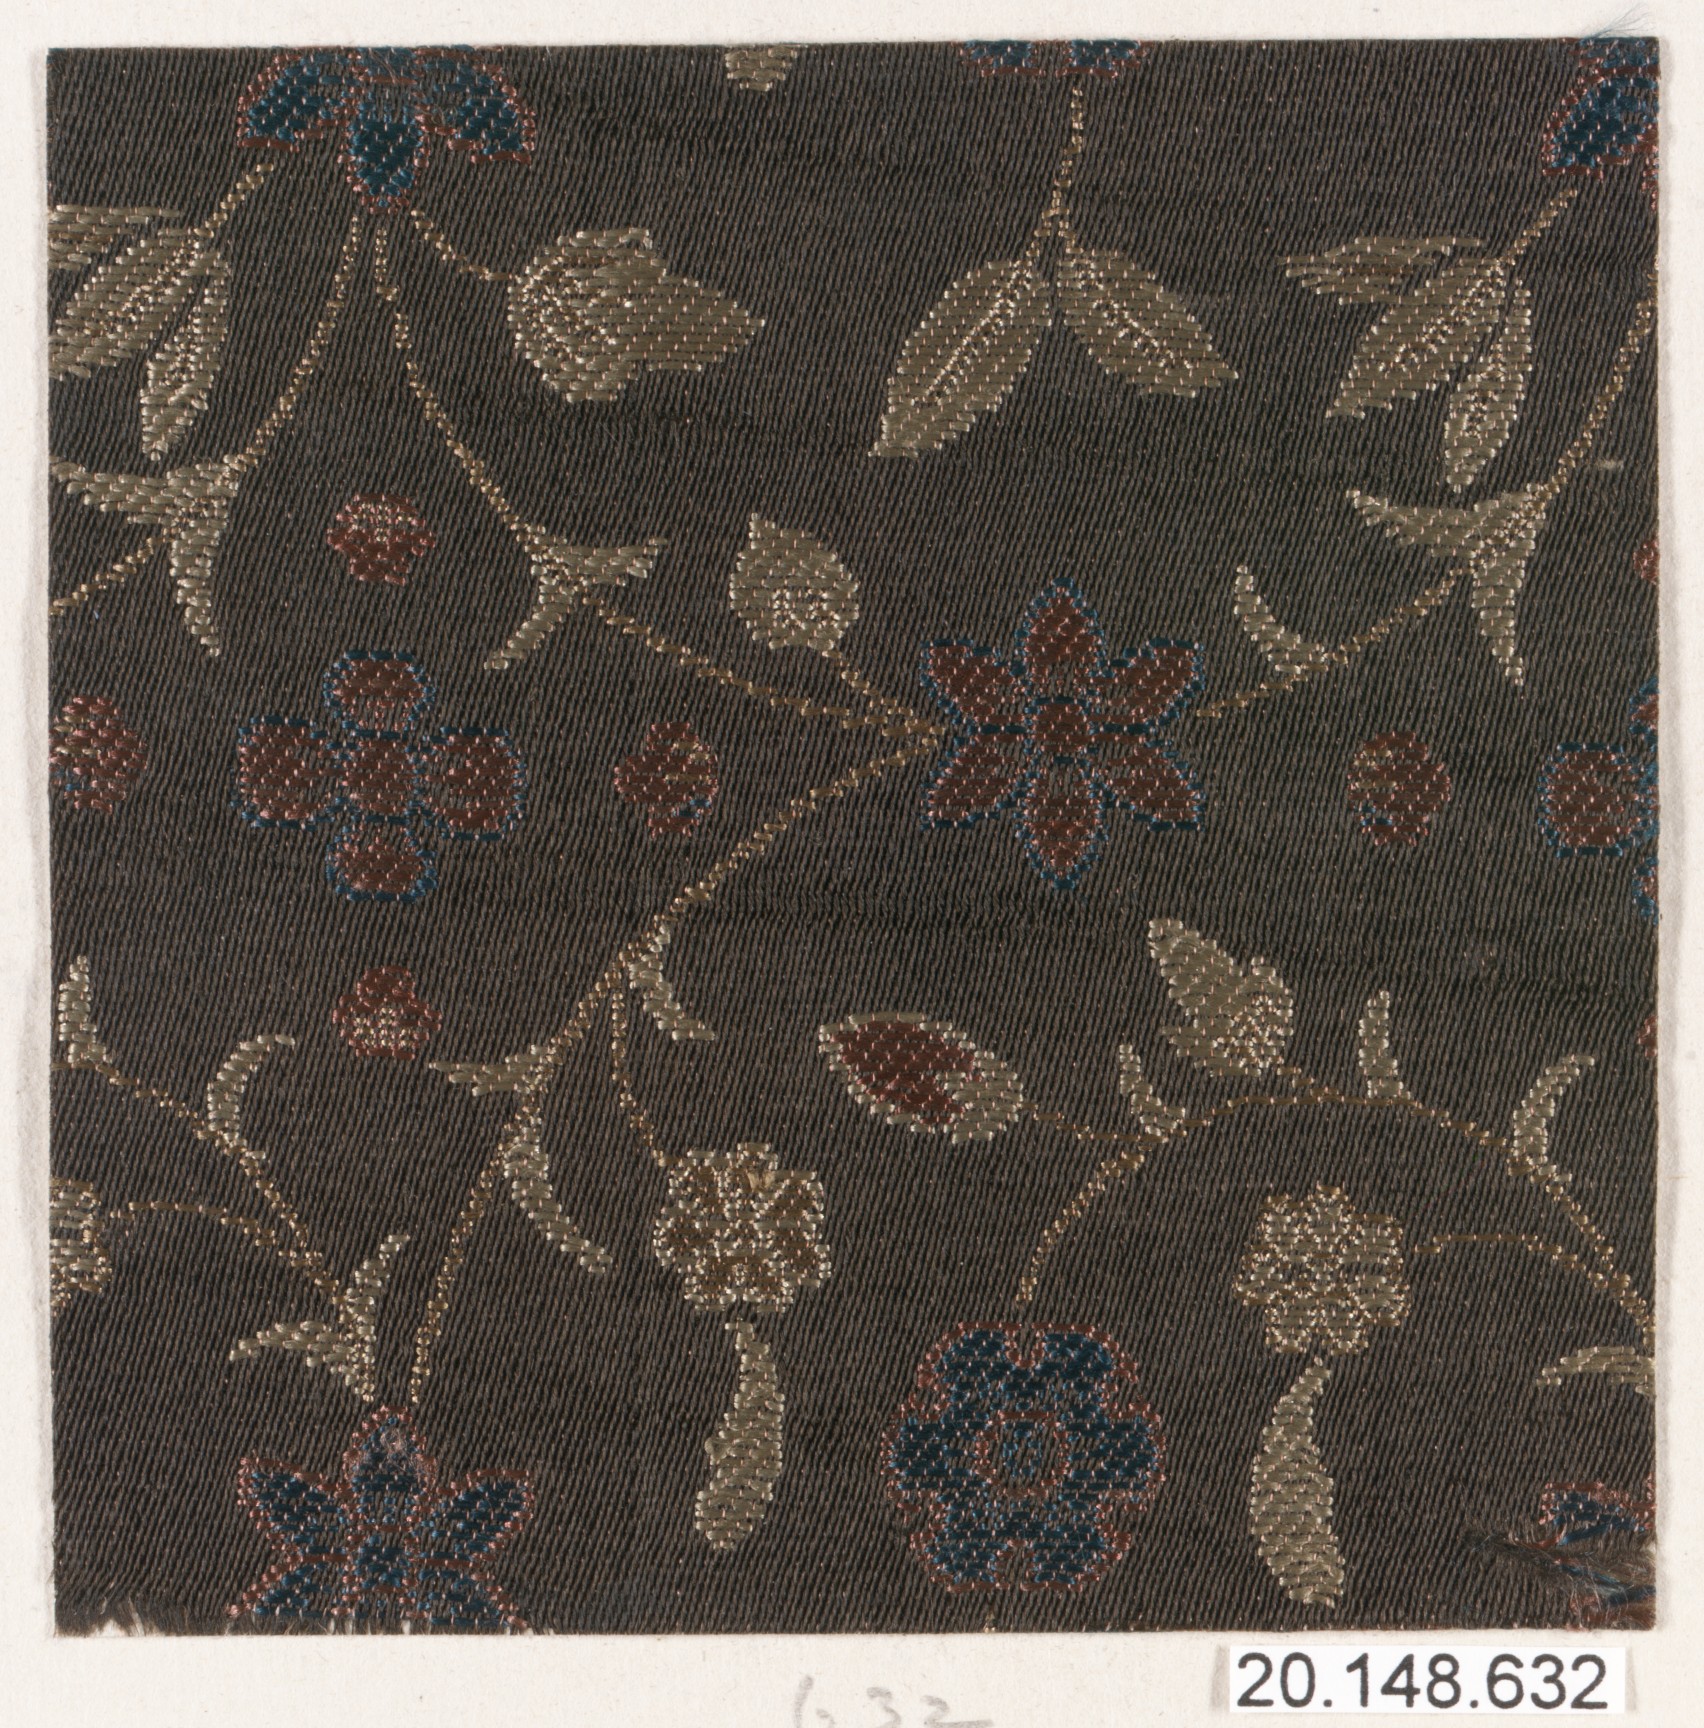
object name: piece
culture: japanese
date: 1701-1800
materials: silk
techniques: compound weave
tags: flowers,leaves